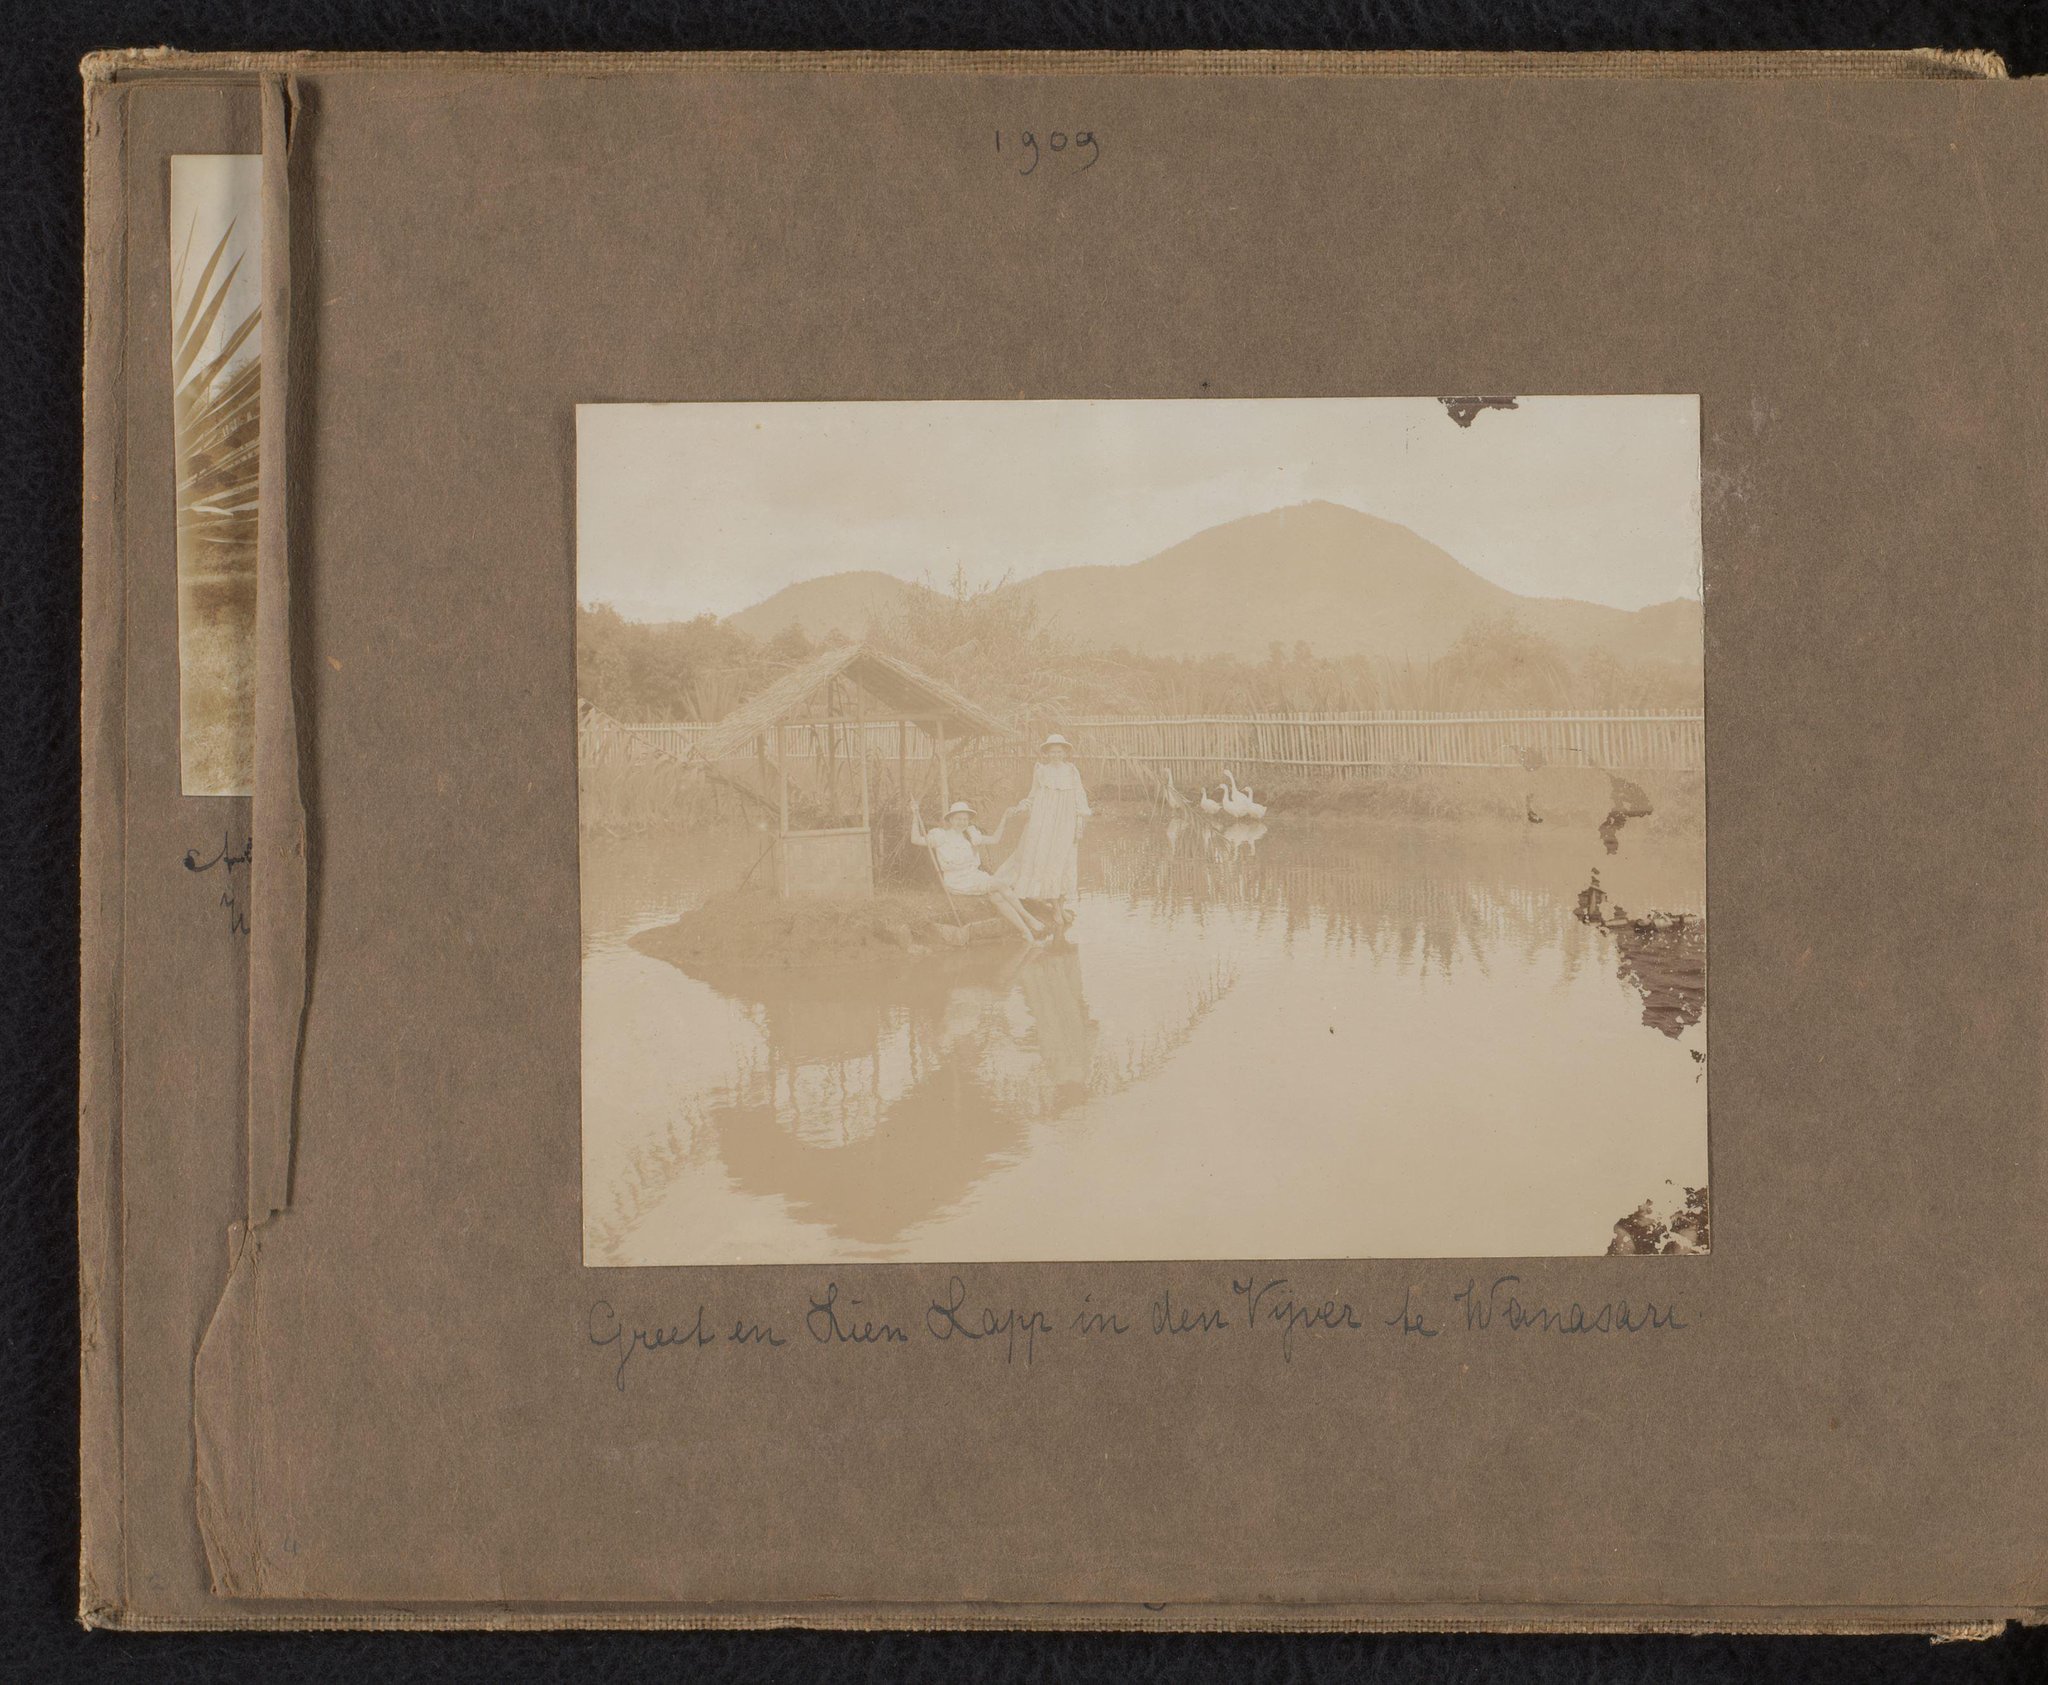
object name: photograph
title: Greet en Lien Lapp in den Vijver te Wanasari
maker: carolina frederika onnen (lien/loen)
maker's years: 1896-1983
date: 1909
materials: paper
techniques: gelatin silver print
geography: central java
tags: historical persons - bb - woman, pond, pool